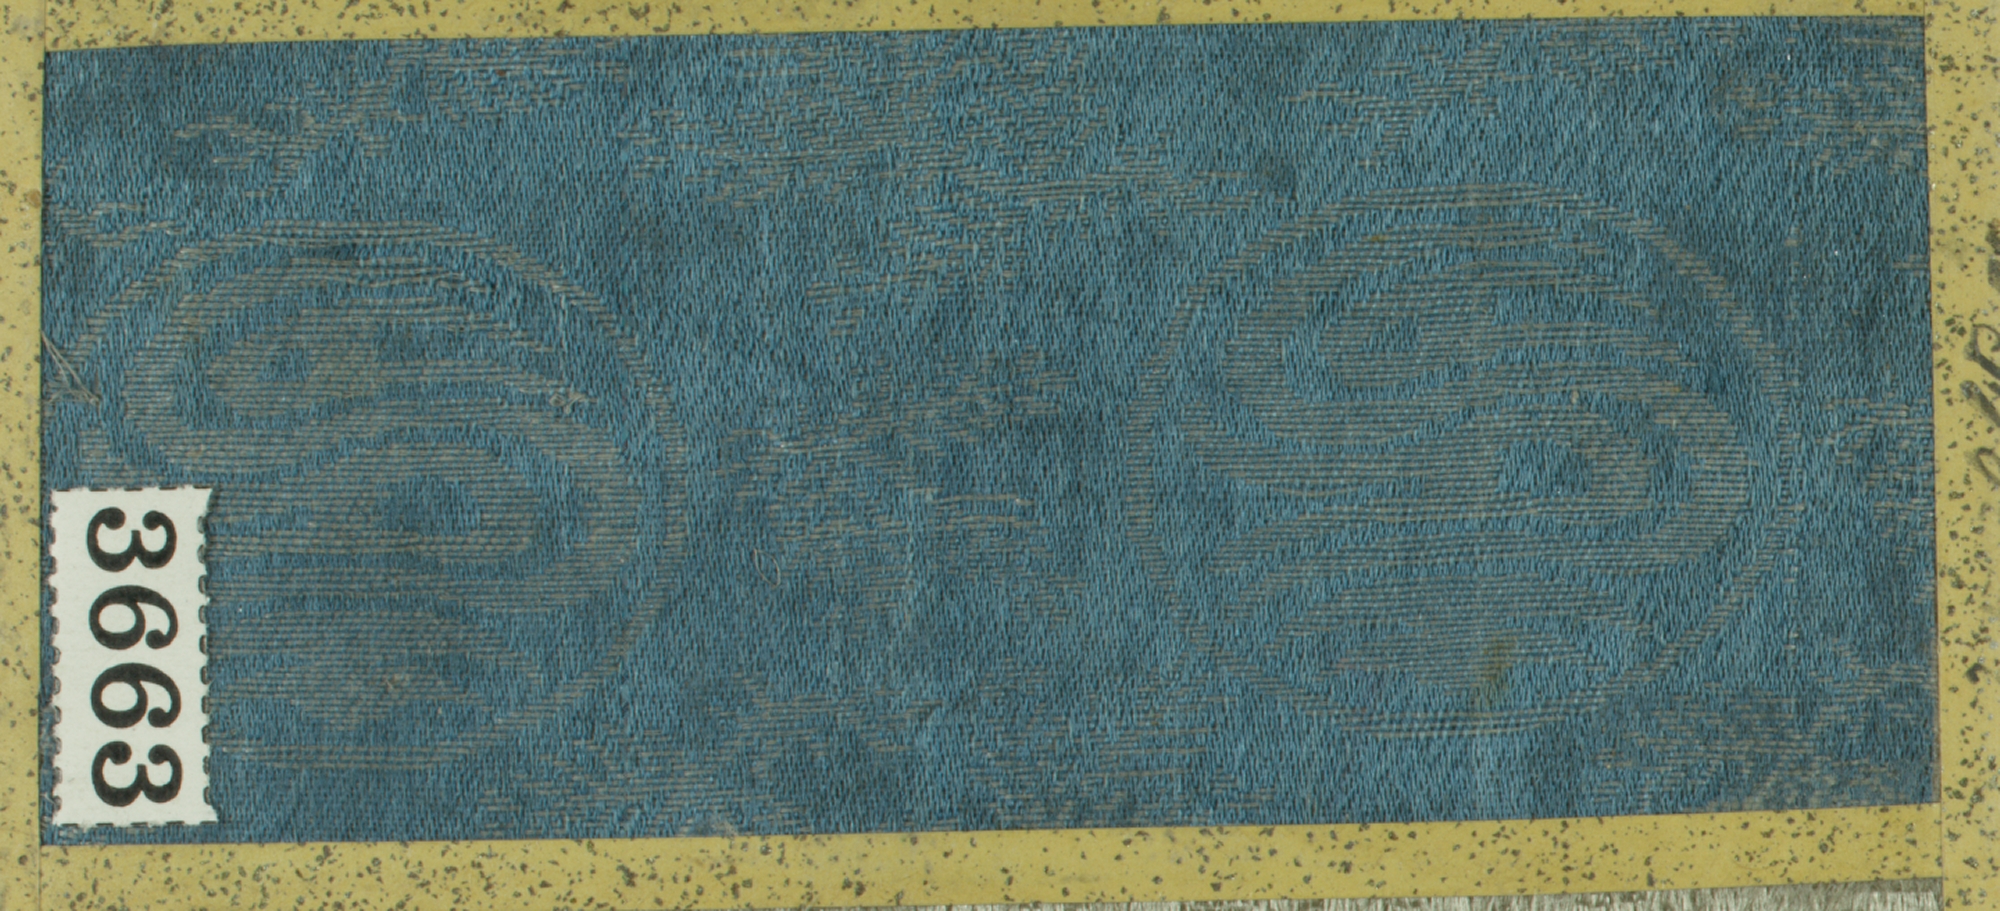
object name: sample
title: Textile Sample from Sample Book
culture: japanese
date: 1801-1900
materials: silk